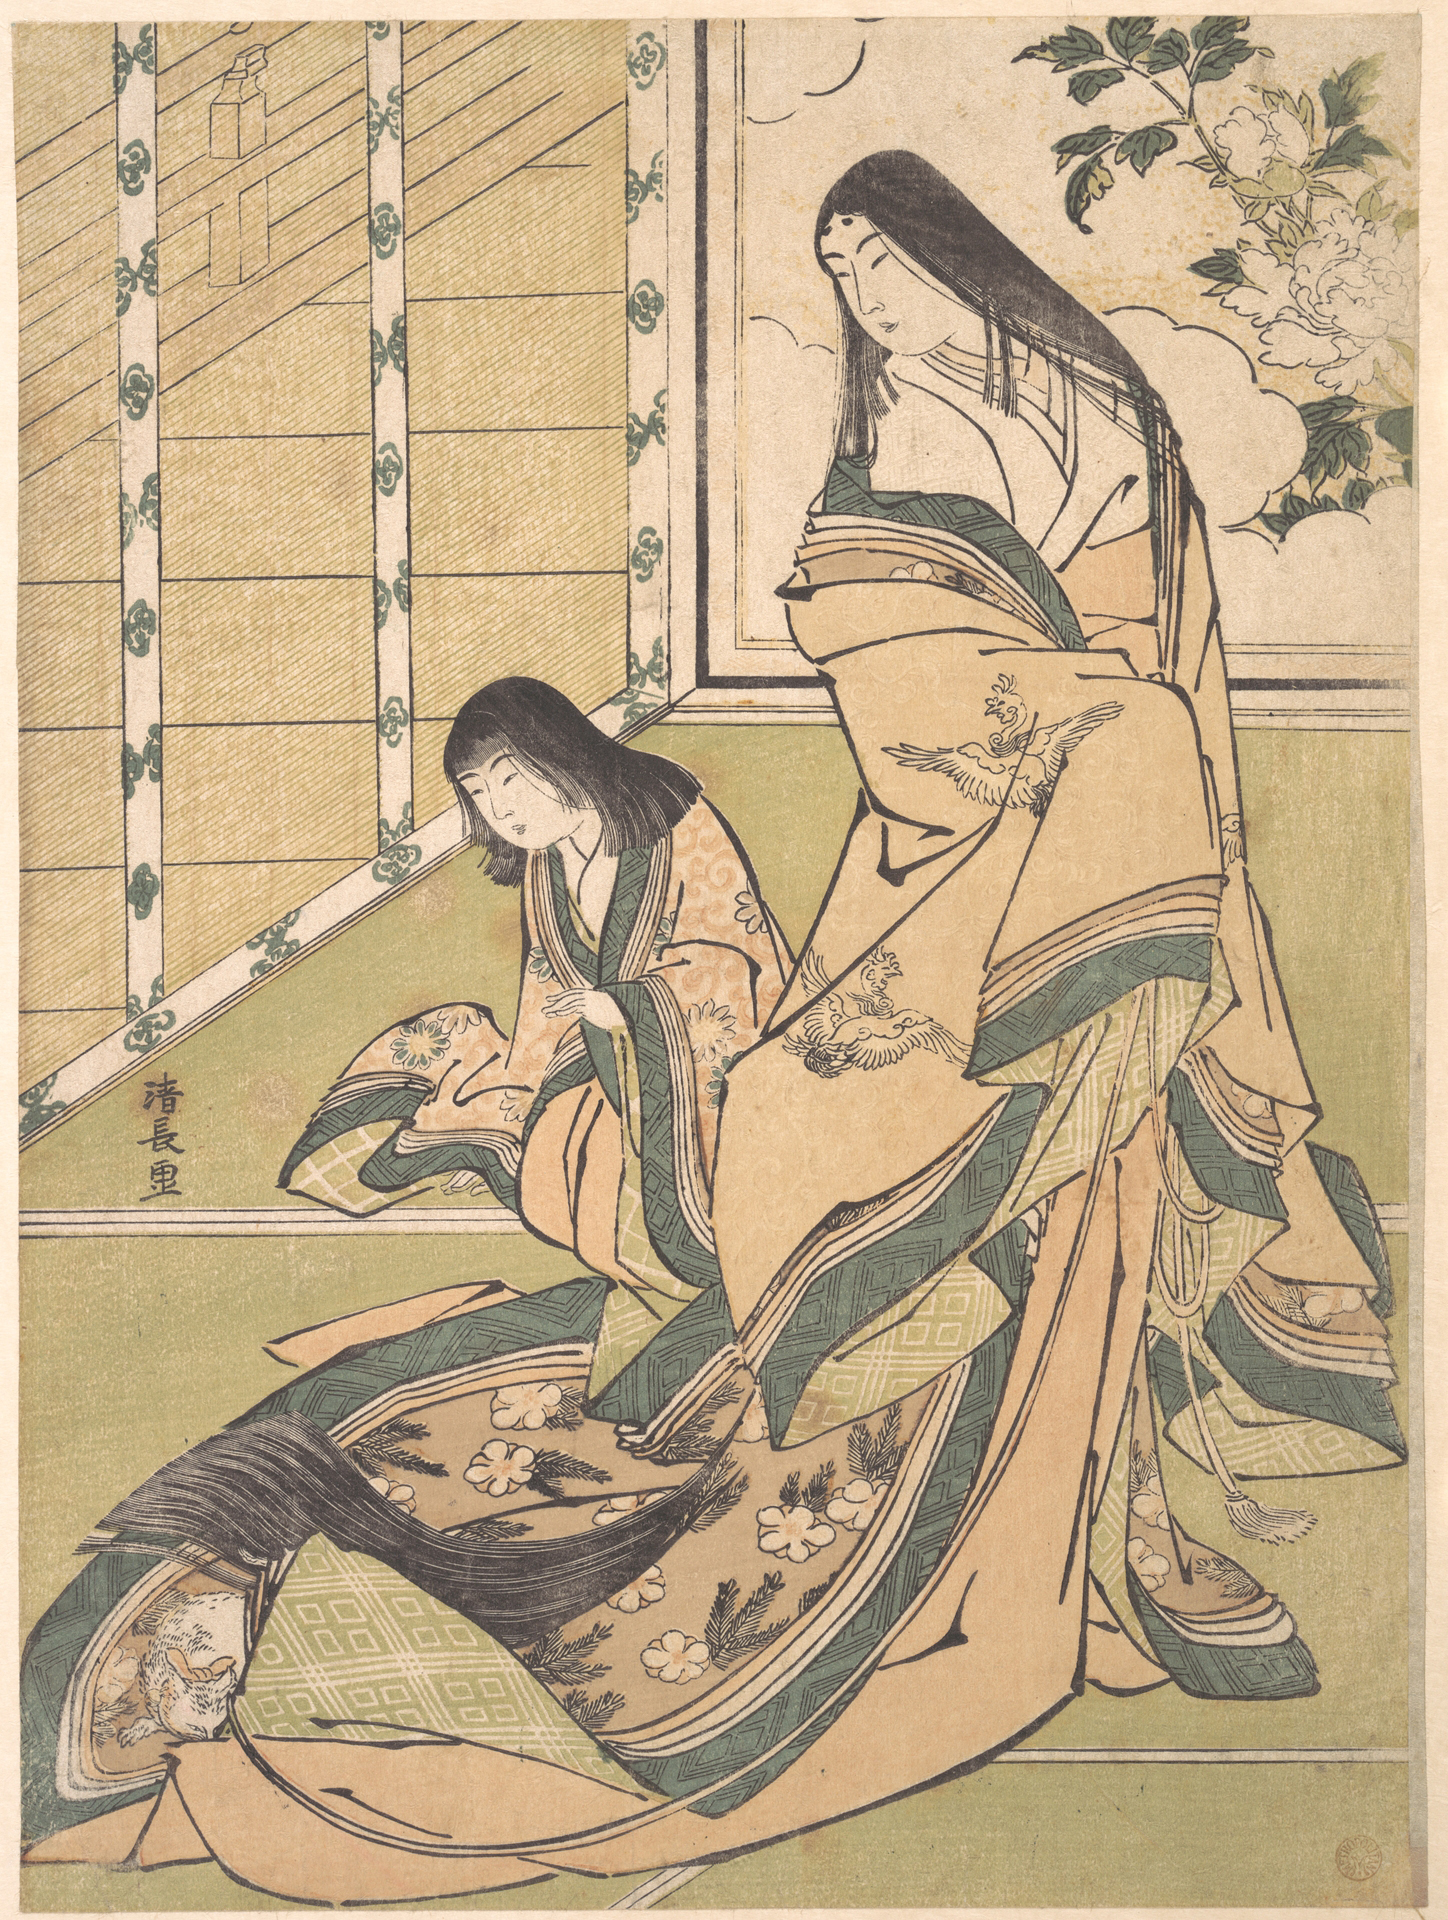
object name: print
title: The Third Princess (Onna San no Miya)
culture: japanese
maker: torii kiyonaga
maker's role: artist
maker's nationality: japanese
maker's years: 1752-1815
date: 1781-1789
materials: ink, paper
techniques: woodblock print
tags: princesses